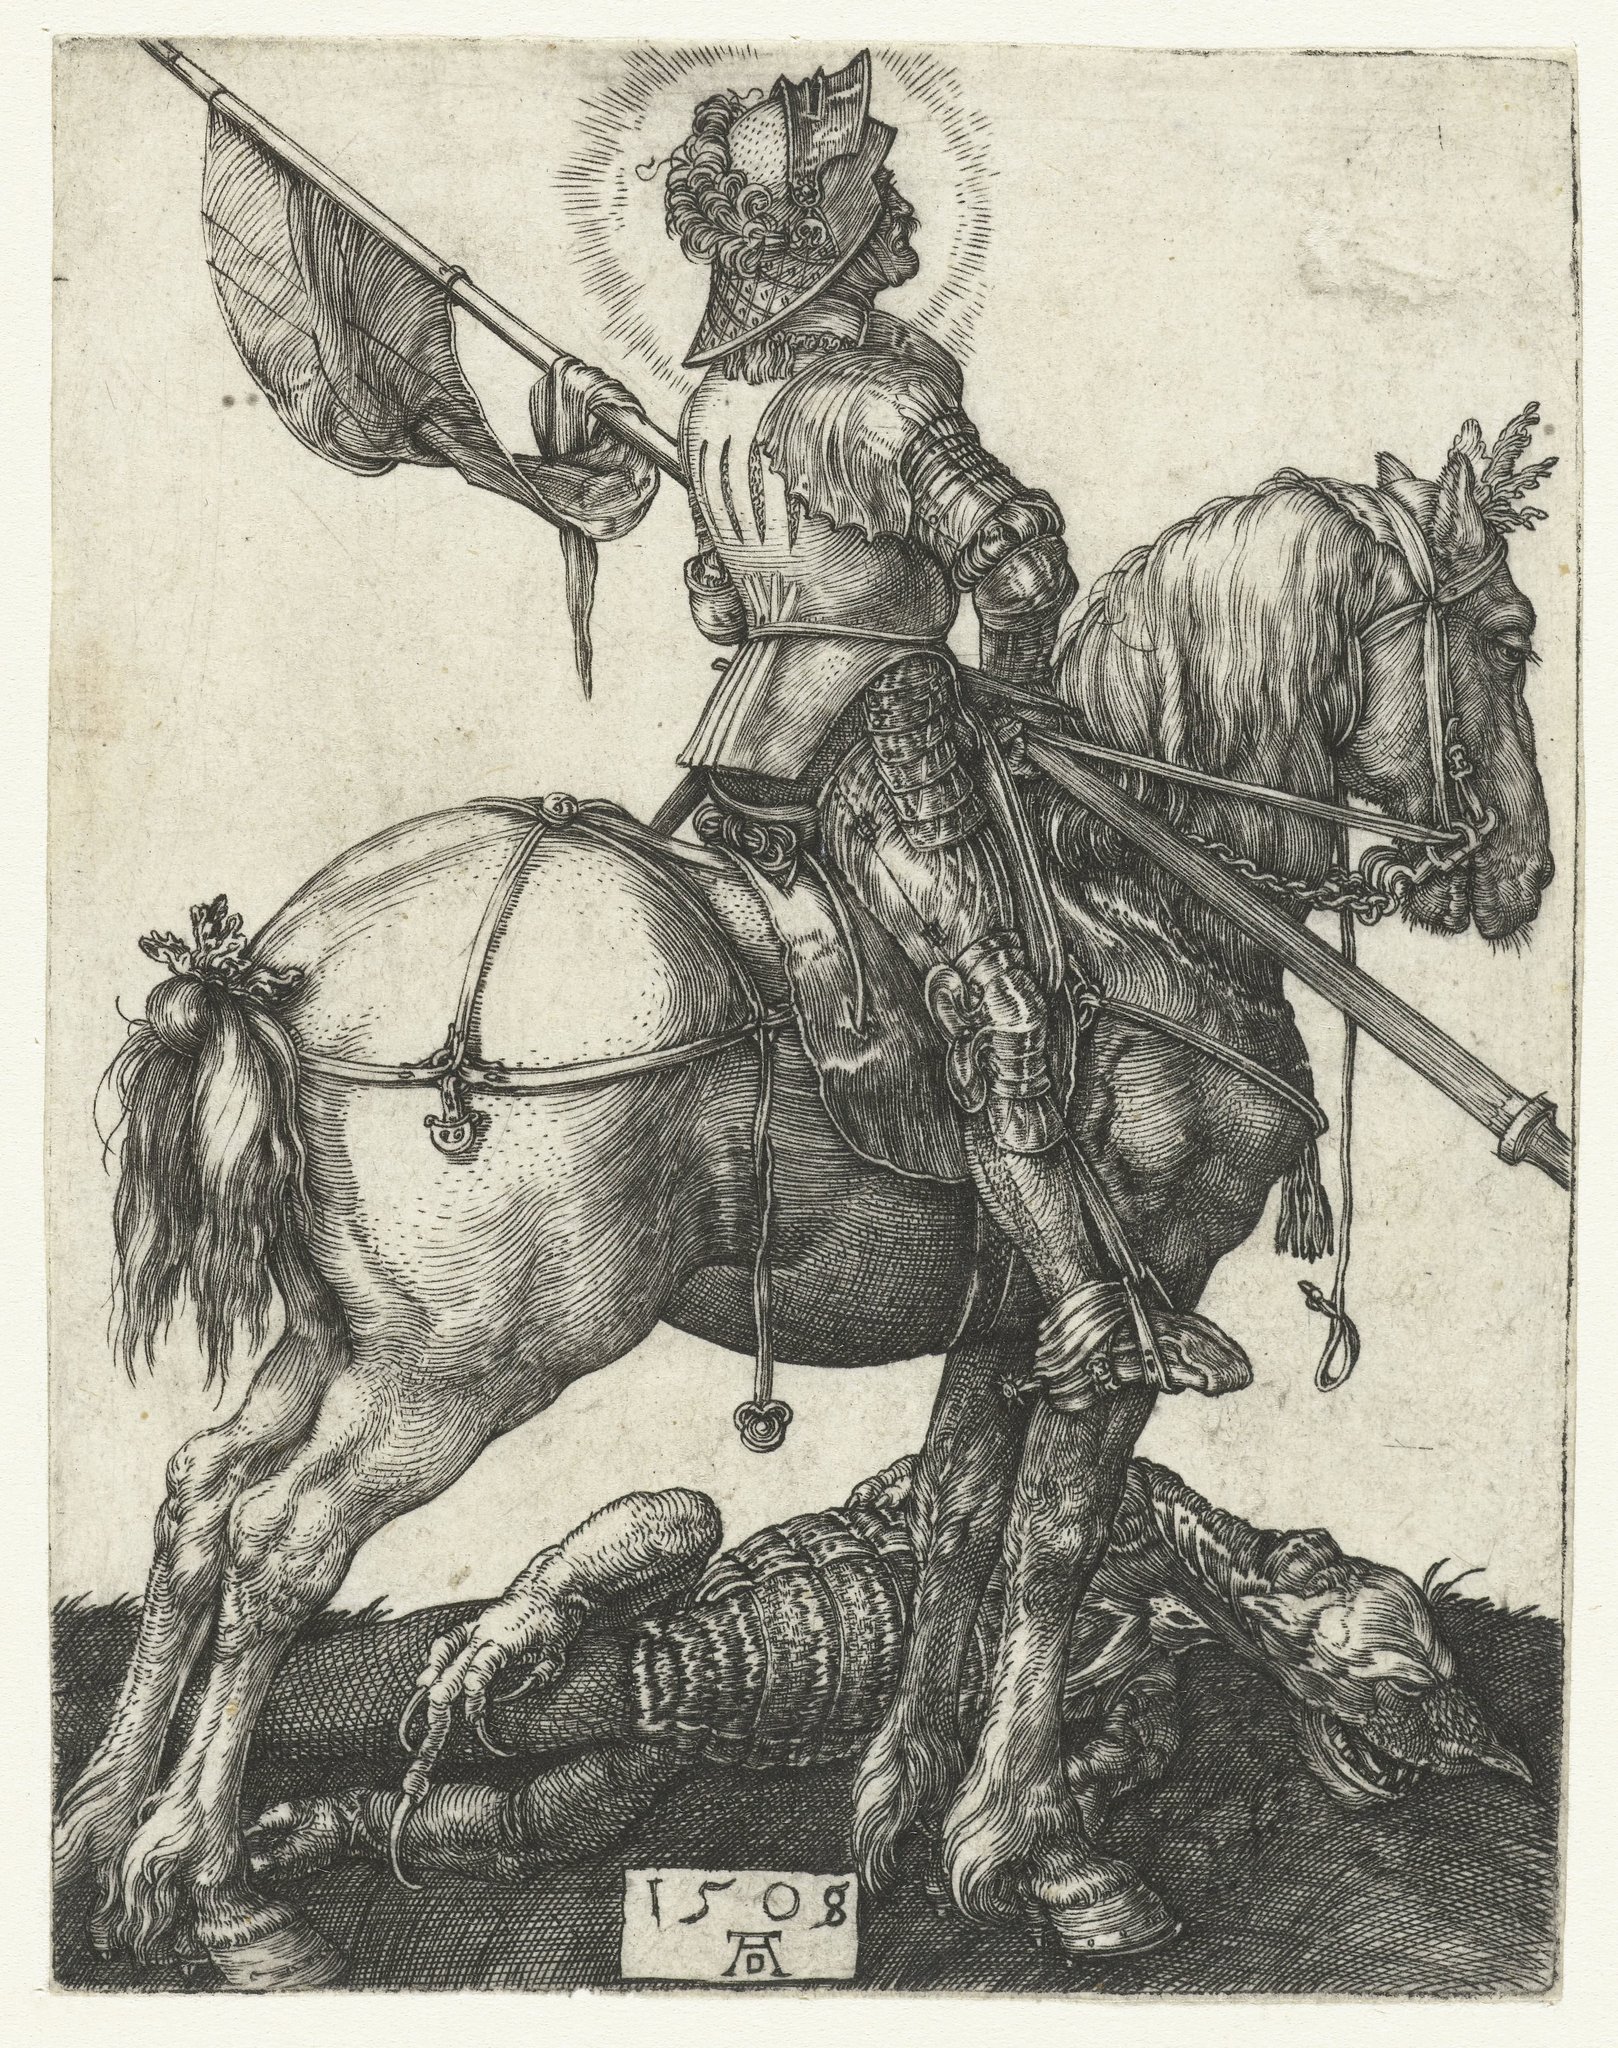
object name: print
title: De Heilige Joris te paard naast de gedode draak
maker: albrecht dürer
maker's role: draughtsman, painter, print maker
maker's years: 1471-1528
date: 1508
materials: paper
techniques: engraving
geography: nuremberg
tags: the warrior martyr george (georgius); possible attributes: banner (red cross on white field), (red) cross, dragon, (white) horse, broken lance, shield (with cross), sword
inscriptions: collector's mark: Lugt 2228a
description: De Heilige Joris, in harnas op zijn paard, naast de draak die hij gedood heeft.